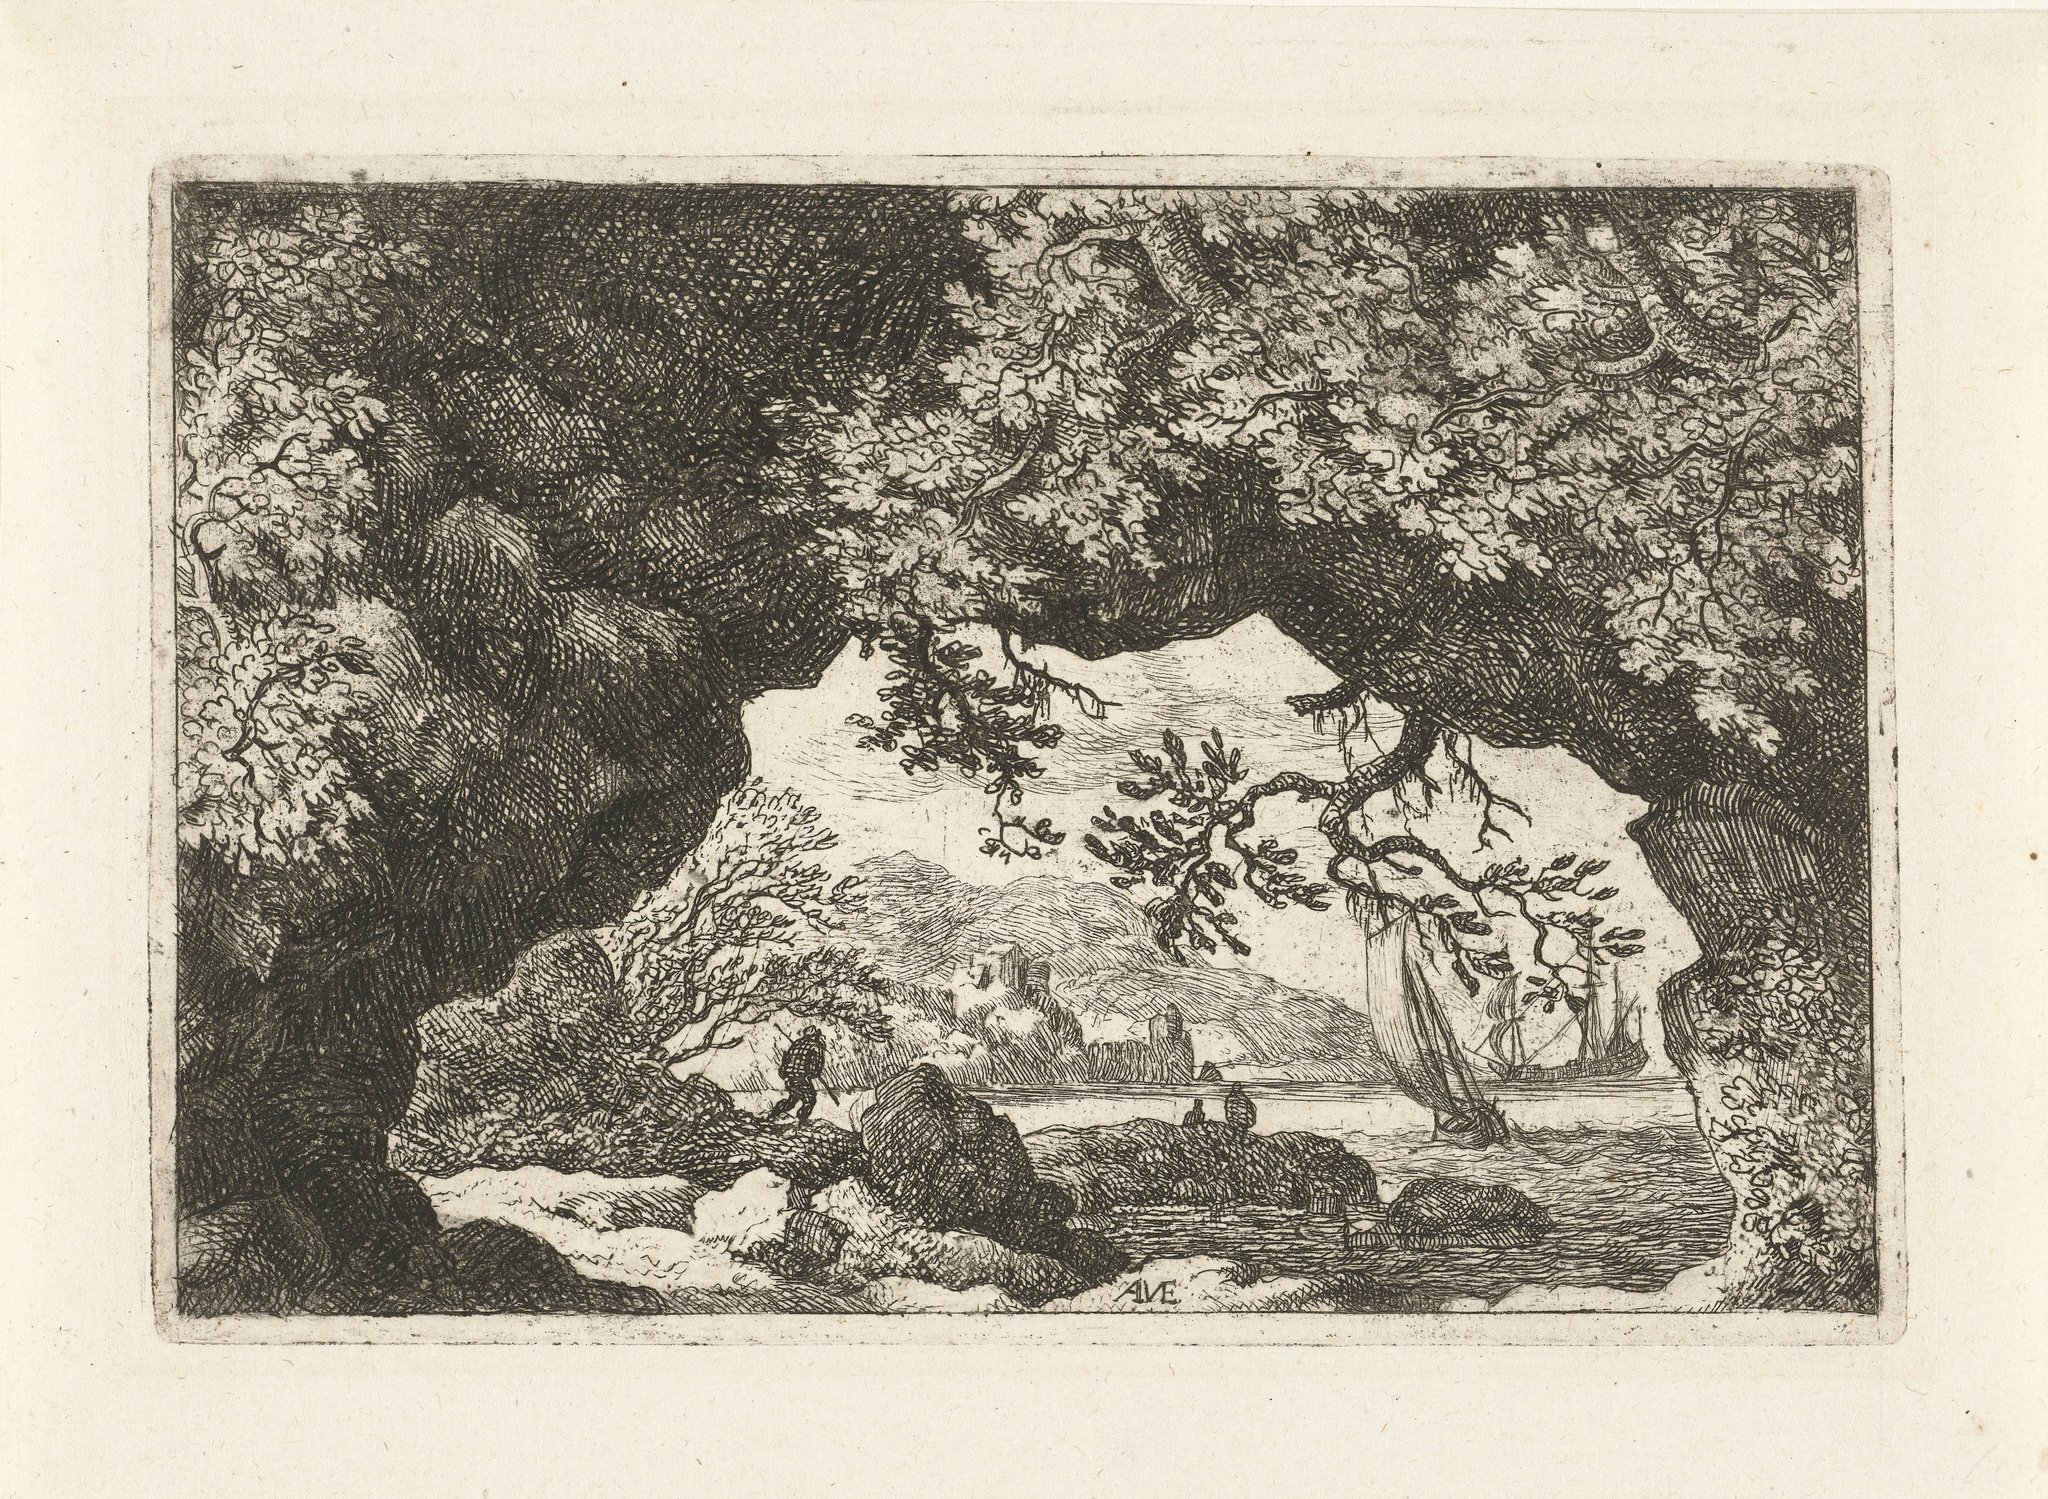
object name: print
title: Zeegezicht door een opening in de rotsen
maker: allaert van everdingen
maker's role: draughtsman, painter, print maker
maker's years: 1621-1675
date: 1651-1675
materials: paper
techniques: etching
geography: netherlands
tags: sea (seascape) (+ landscape with figures, staffage)